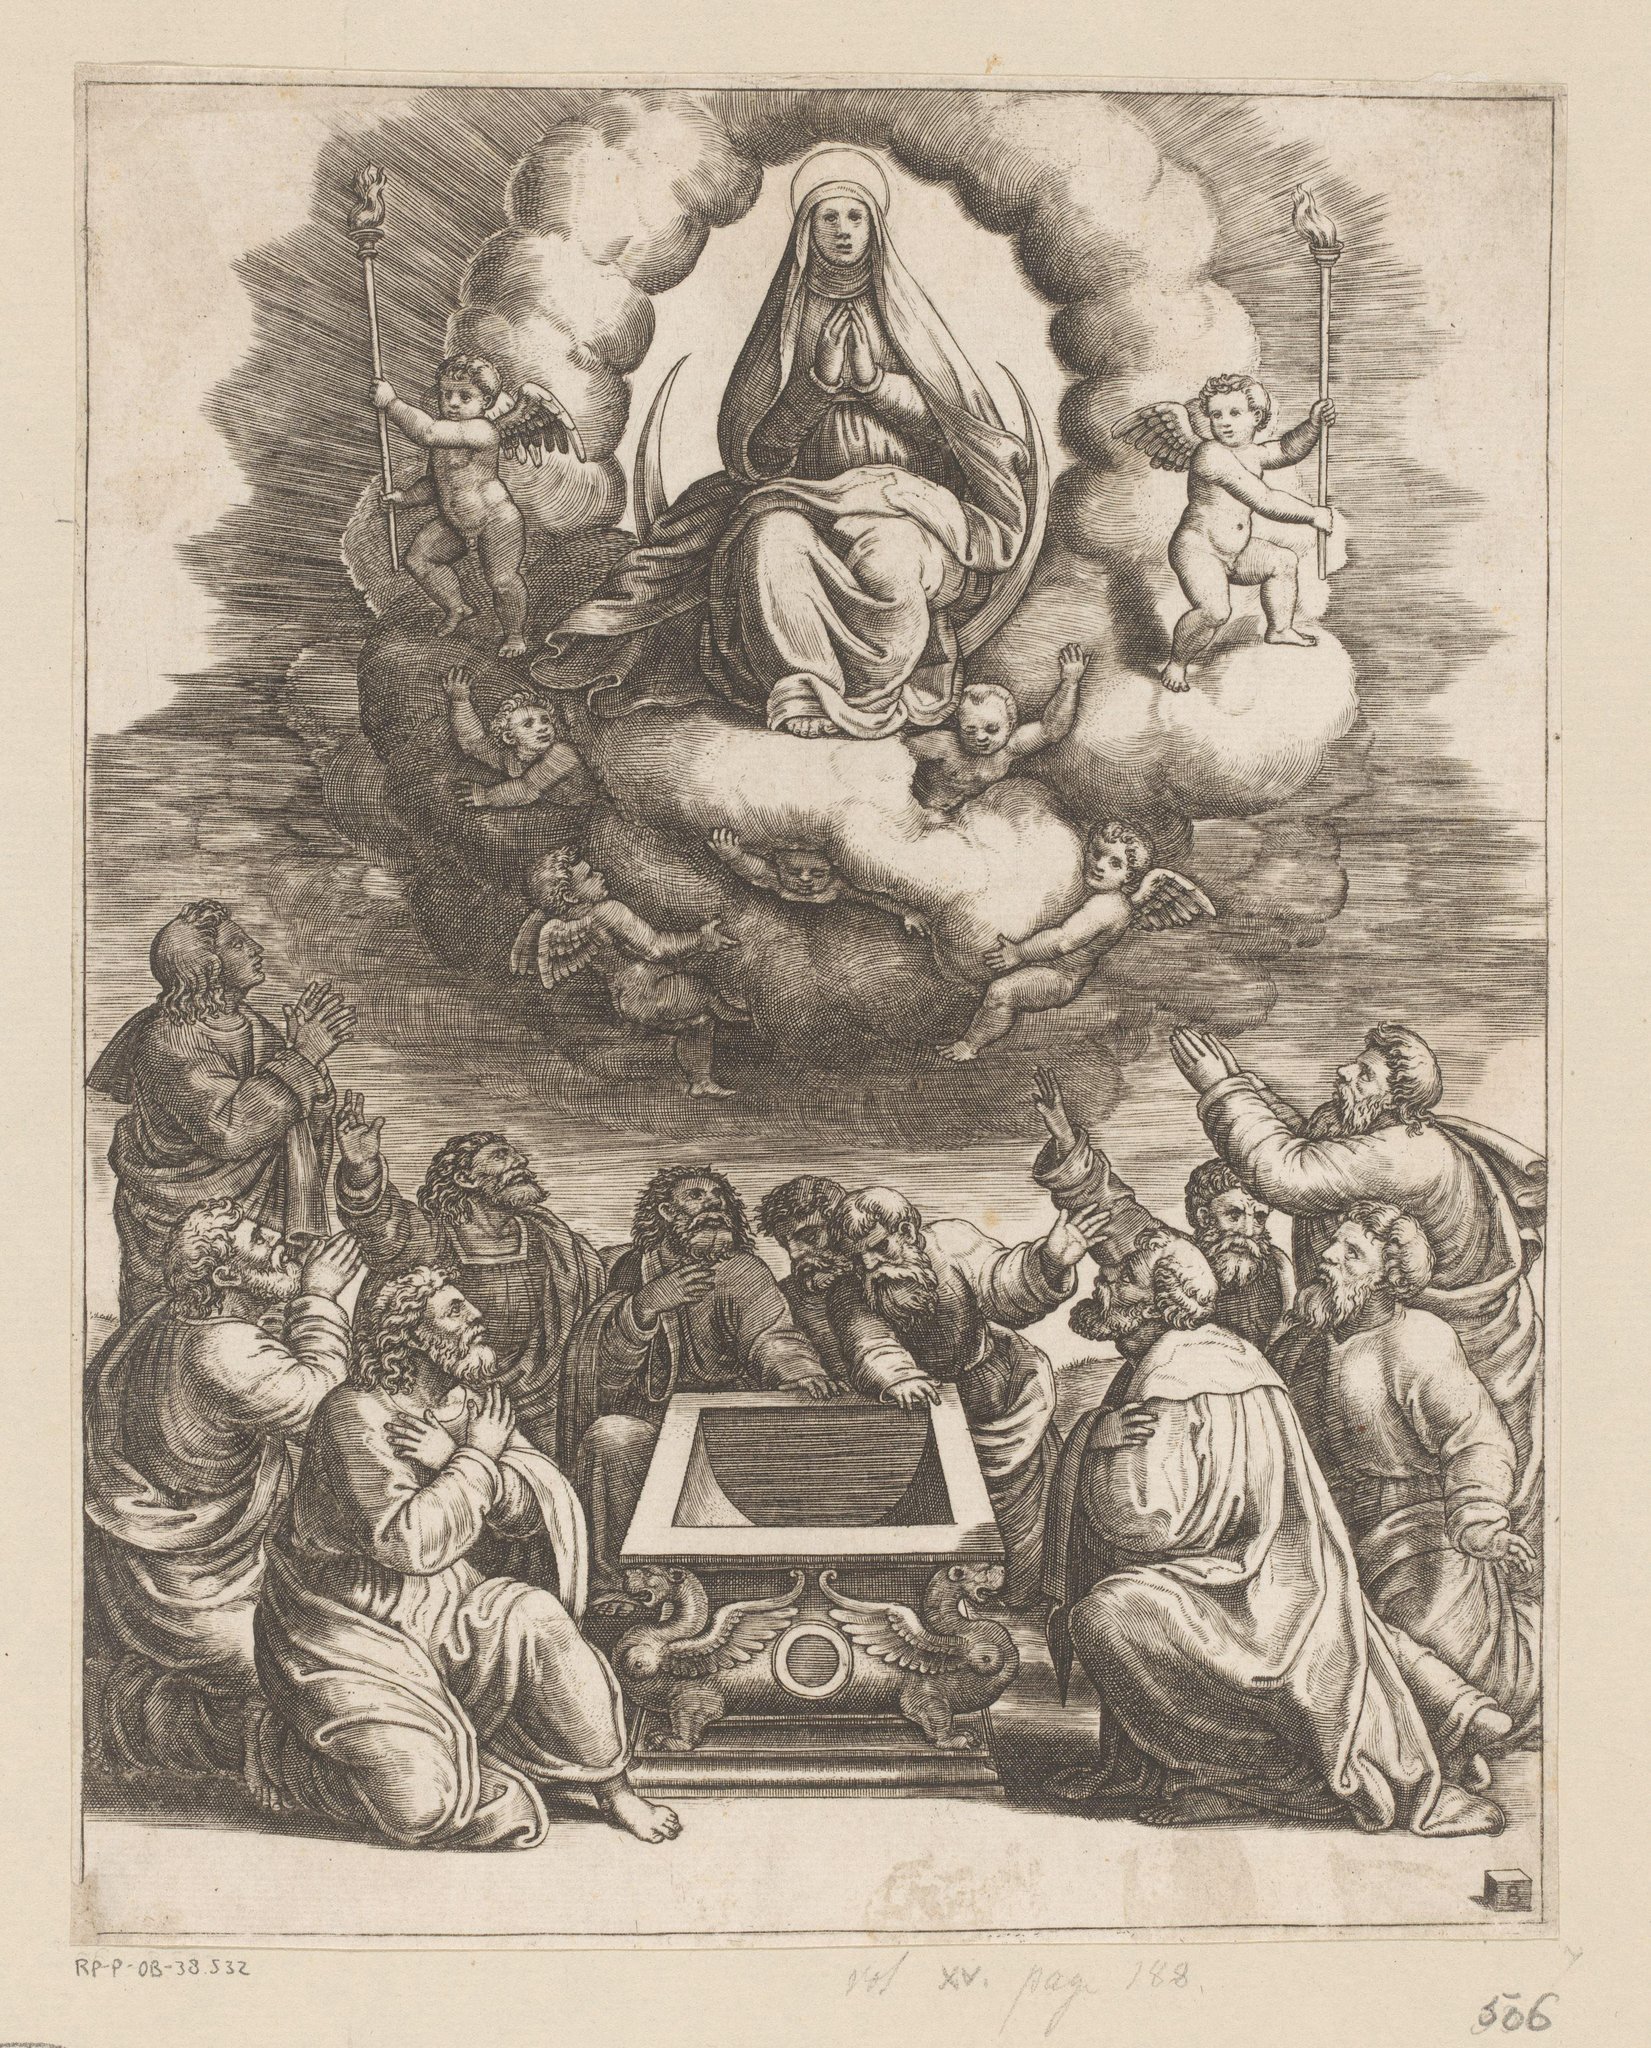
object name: print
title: Hemelvaart van Maria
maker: meester van de dobbelsteen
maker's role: print maker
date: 1530-1560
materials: paper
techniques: engraving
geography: italy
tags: the assumption of mary ('assumptio corporis'): she is borne into heaven by angels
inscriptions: collector's mark: Lugt 240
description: De Hemelvaart van Maria in aanwezigheid van de apostelen. Maria wordt omgeven door wolken en engelen die haar naar de hemel dragen.